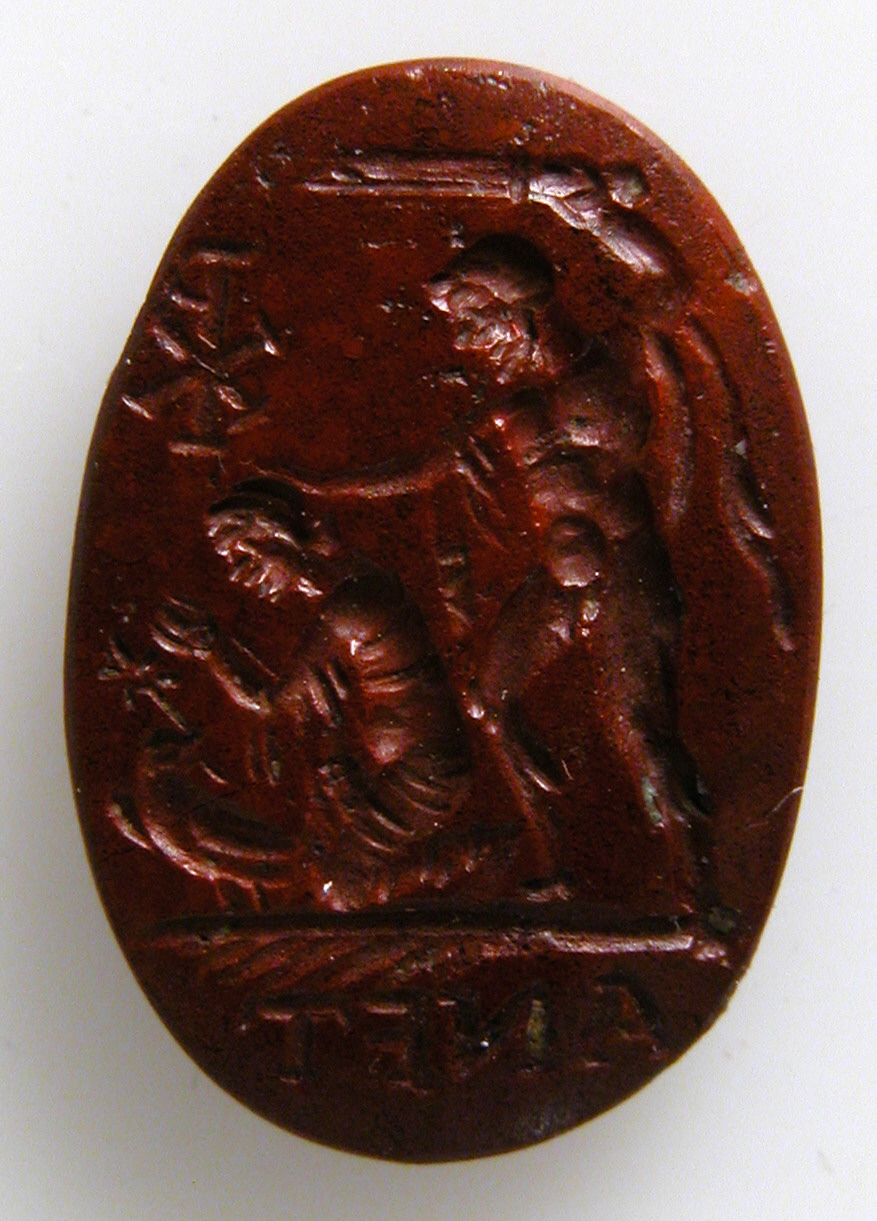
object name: intaglio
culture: roman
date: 201-400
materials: jasper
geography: rome ?